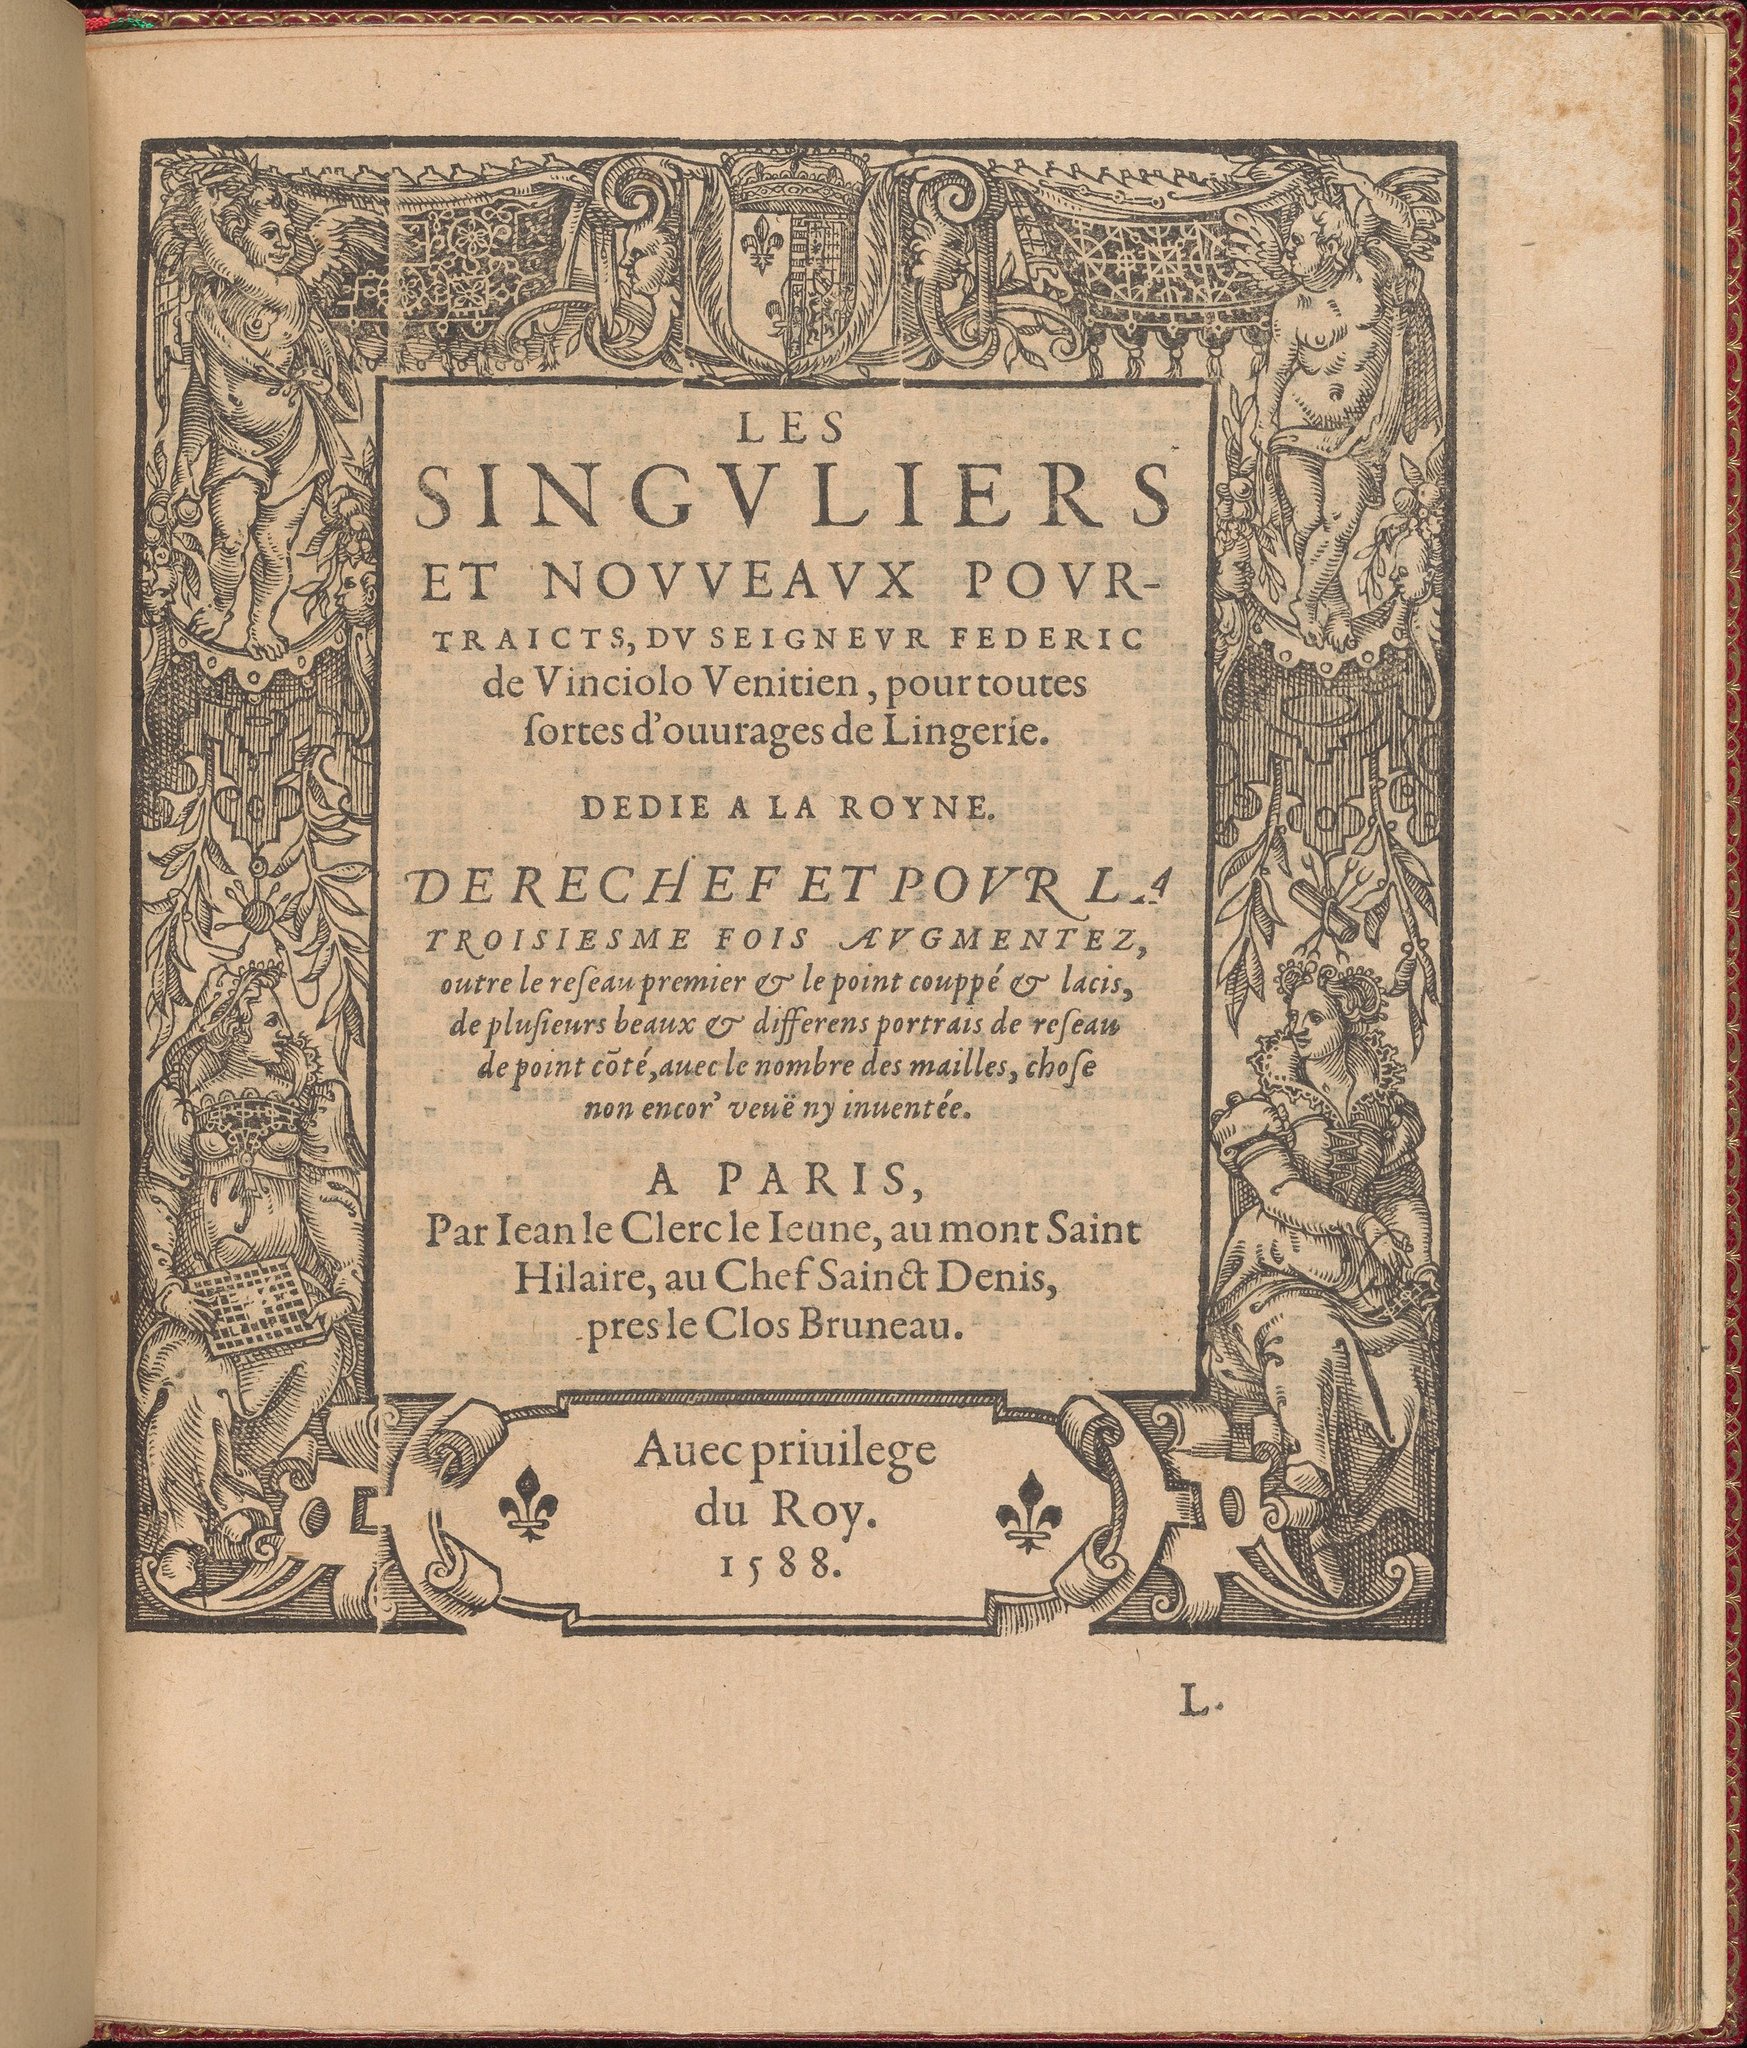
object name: book print ornament architecture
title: Les Singuliers et Nouveaux Portraicts... page 41 (recto)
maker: federico de vinciolo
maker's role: designer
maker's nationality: italian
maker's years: 1582-1599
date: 1588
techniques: woodcut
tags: women,coat of arms